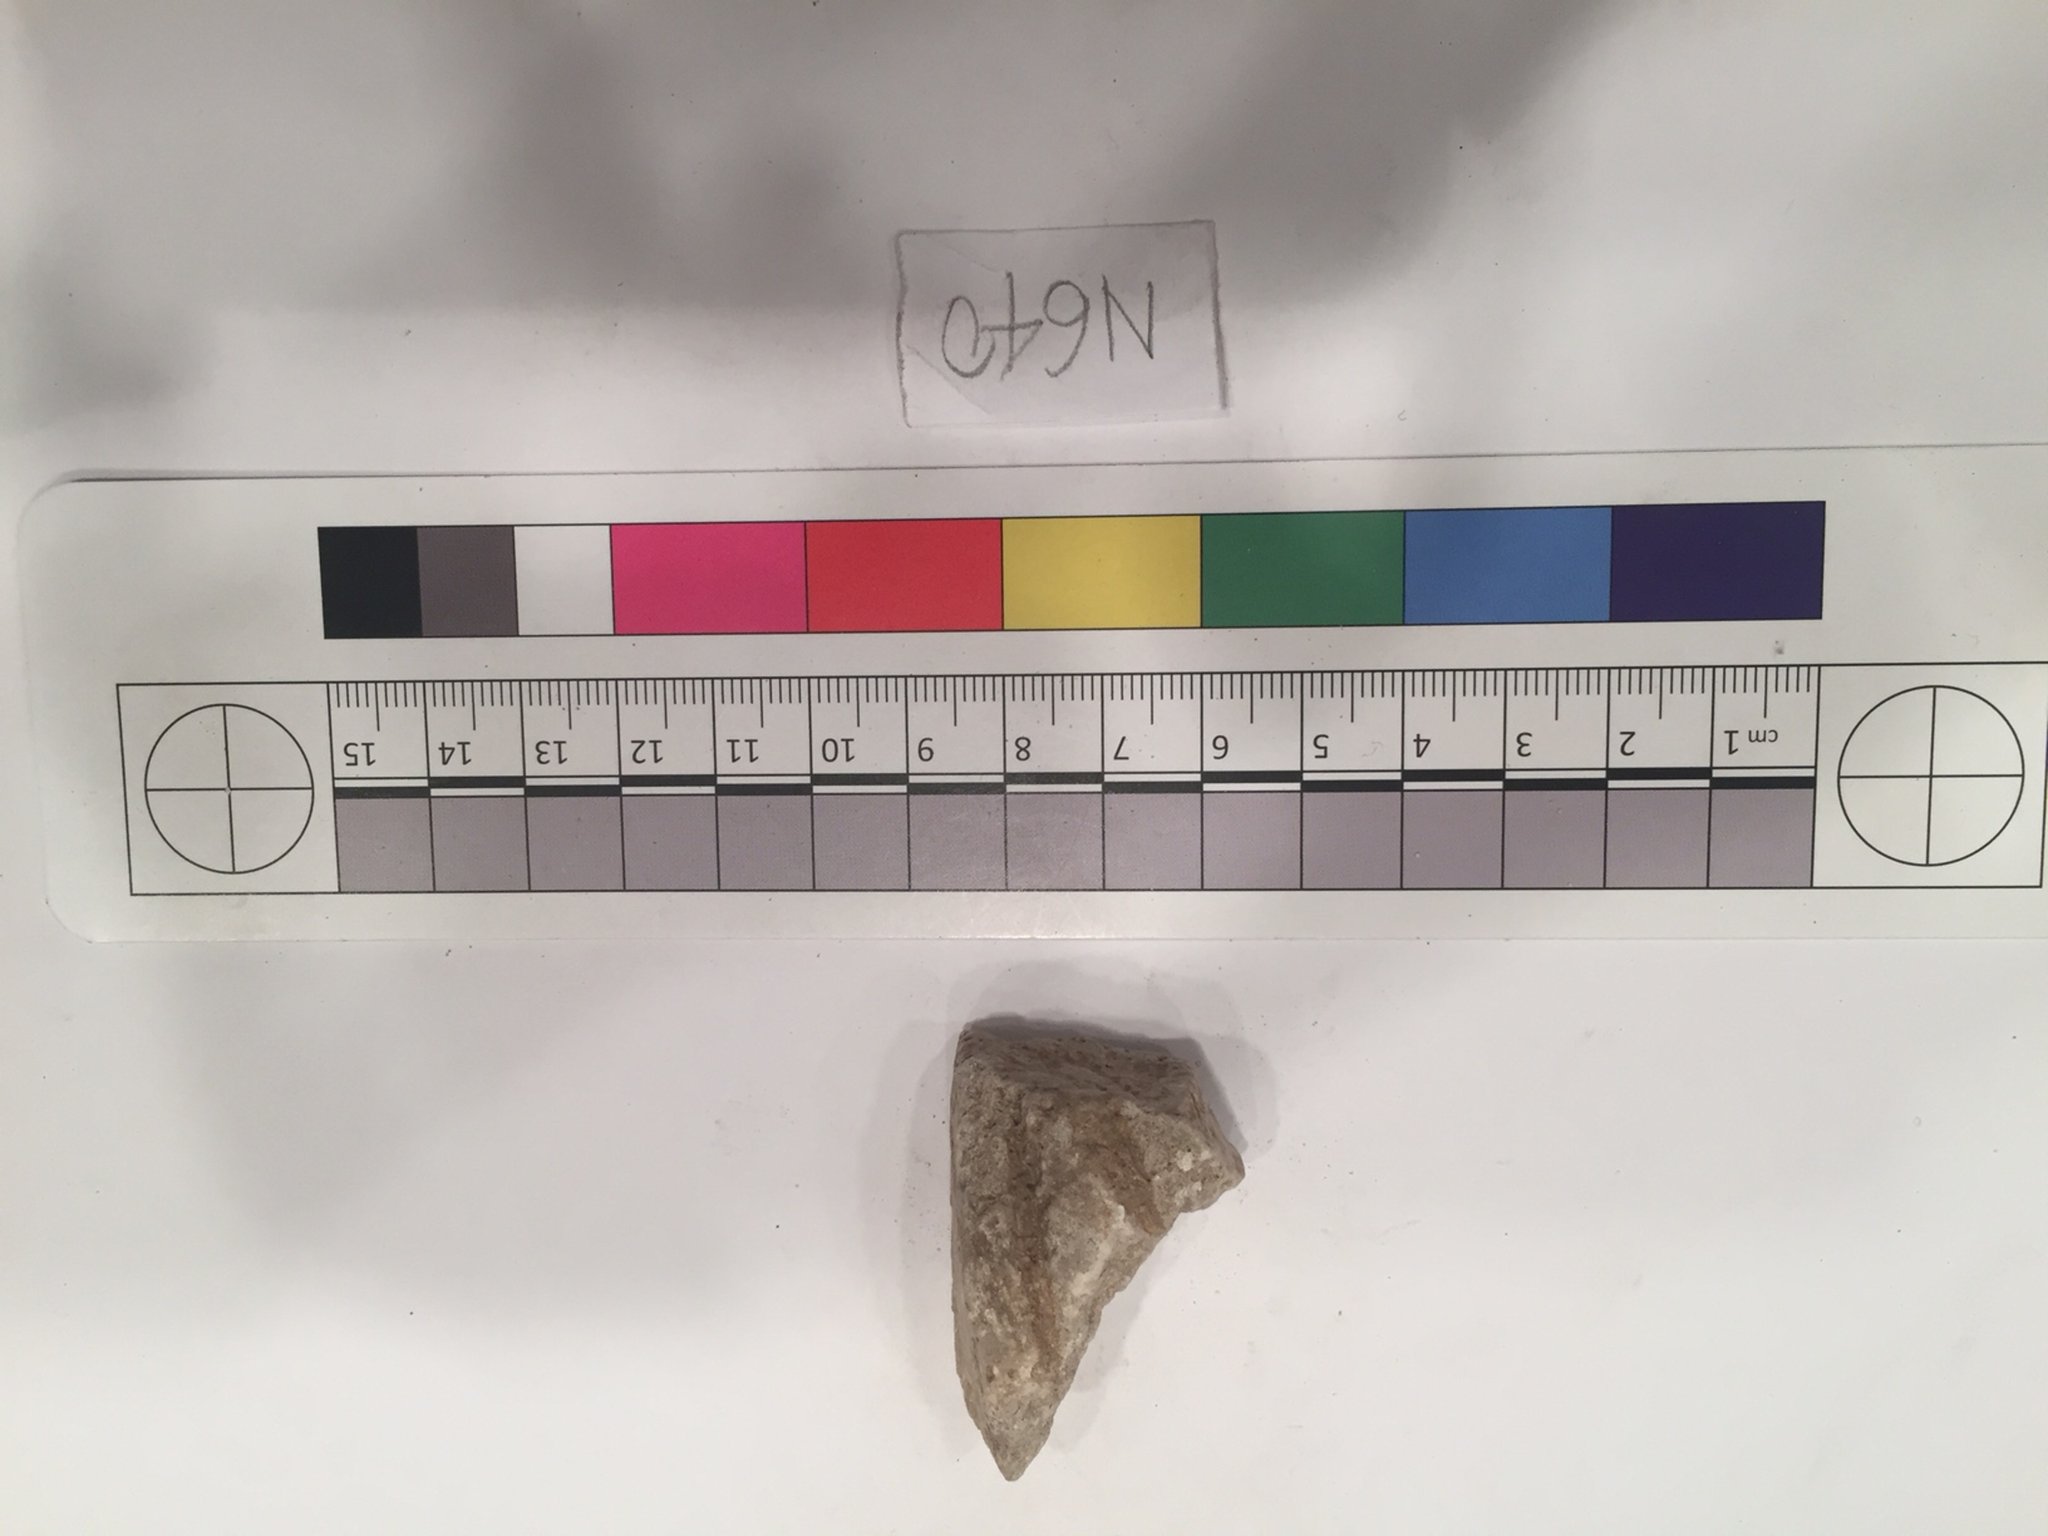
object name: fragment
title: Stucco Fragment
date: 701-1200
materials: plaster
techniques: carving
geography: iran